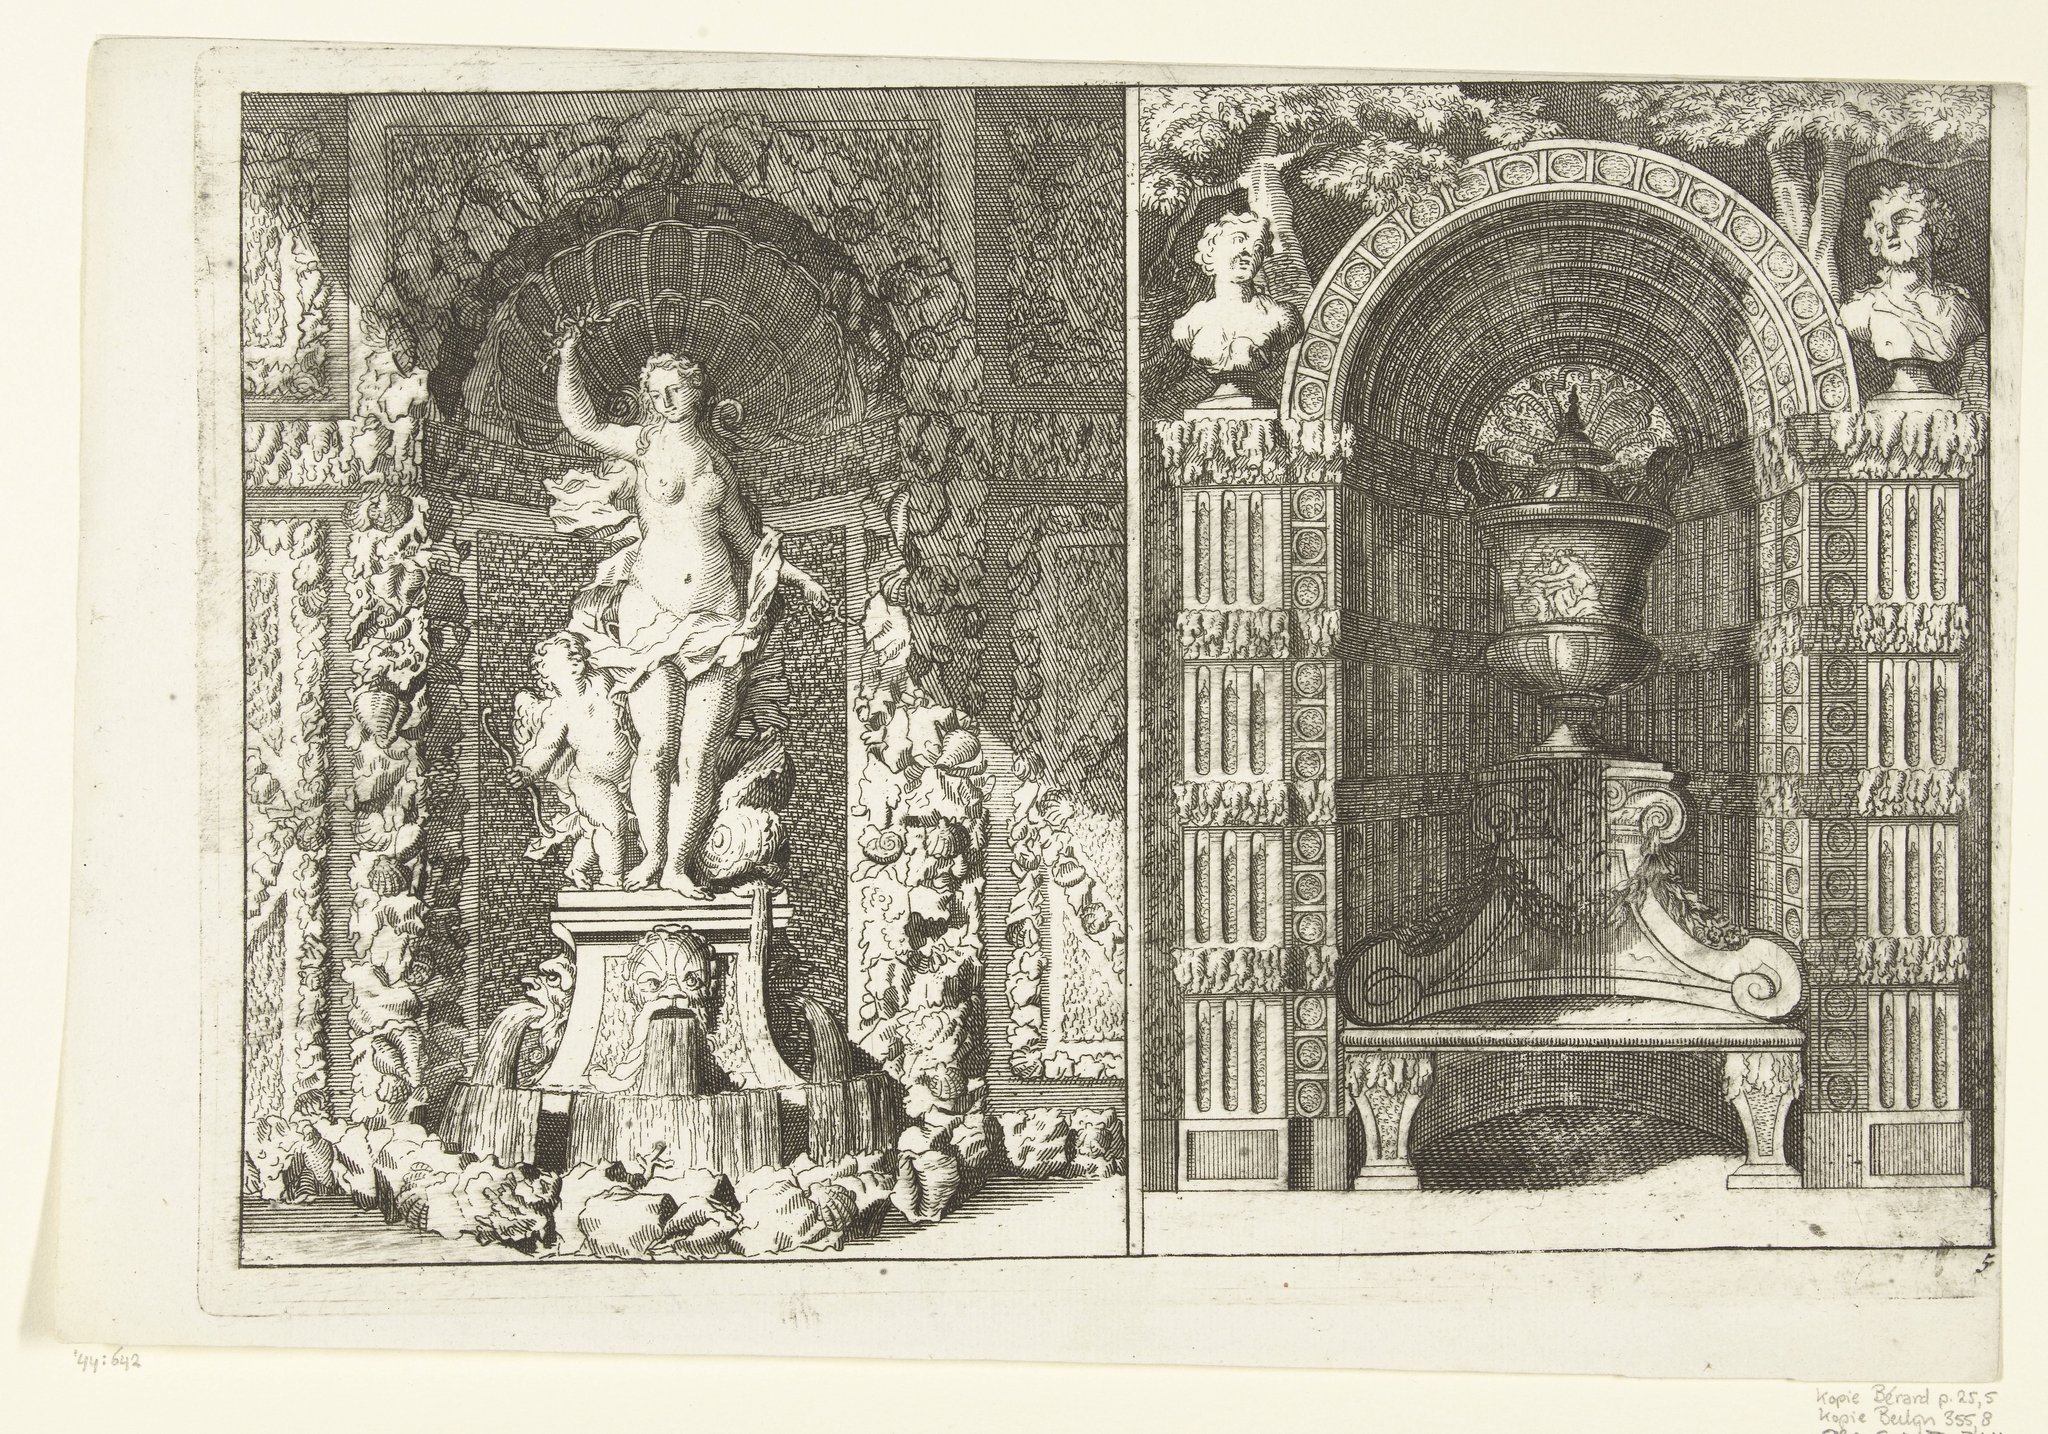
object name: ornament print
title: Nissen met beeld Venus en een vaas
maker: Anonymous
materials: paper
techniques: etching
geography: netherlands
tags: trellis, garden cascade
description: De rechter nis met latwerk en een bank bekroond met een vaas, de linker met een standbeeld van Venus en Amor. Tegenzijdige kopie naar blad uit serie Nouveaux Liure de Bersseaux et Trilliages uitgegeven door Daniel Marot.